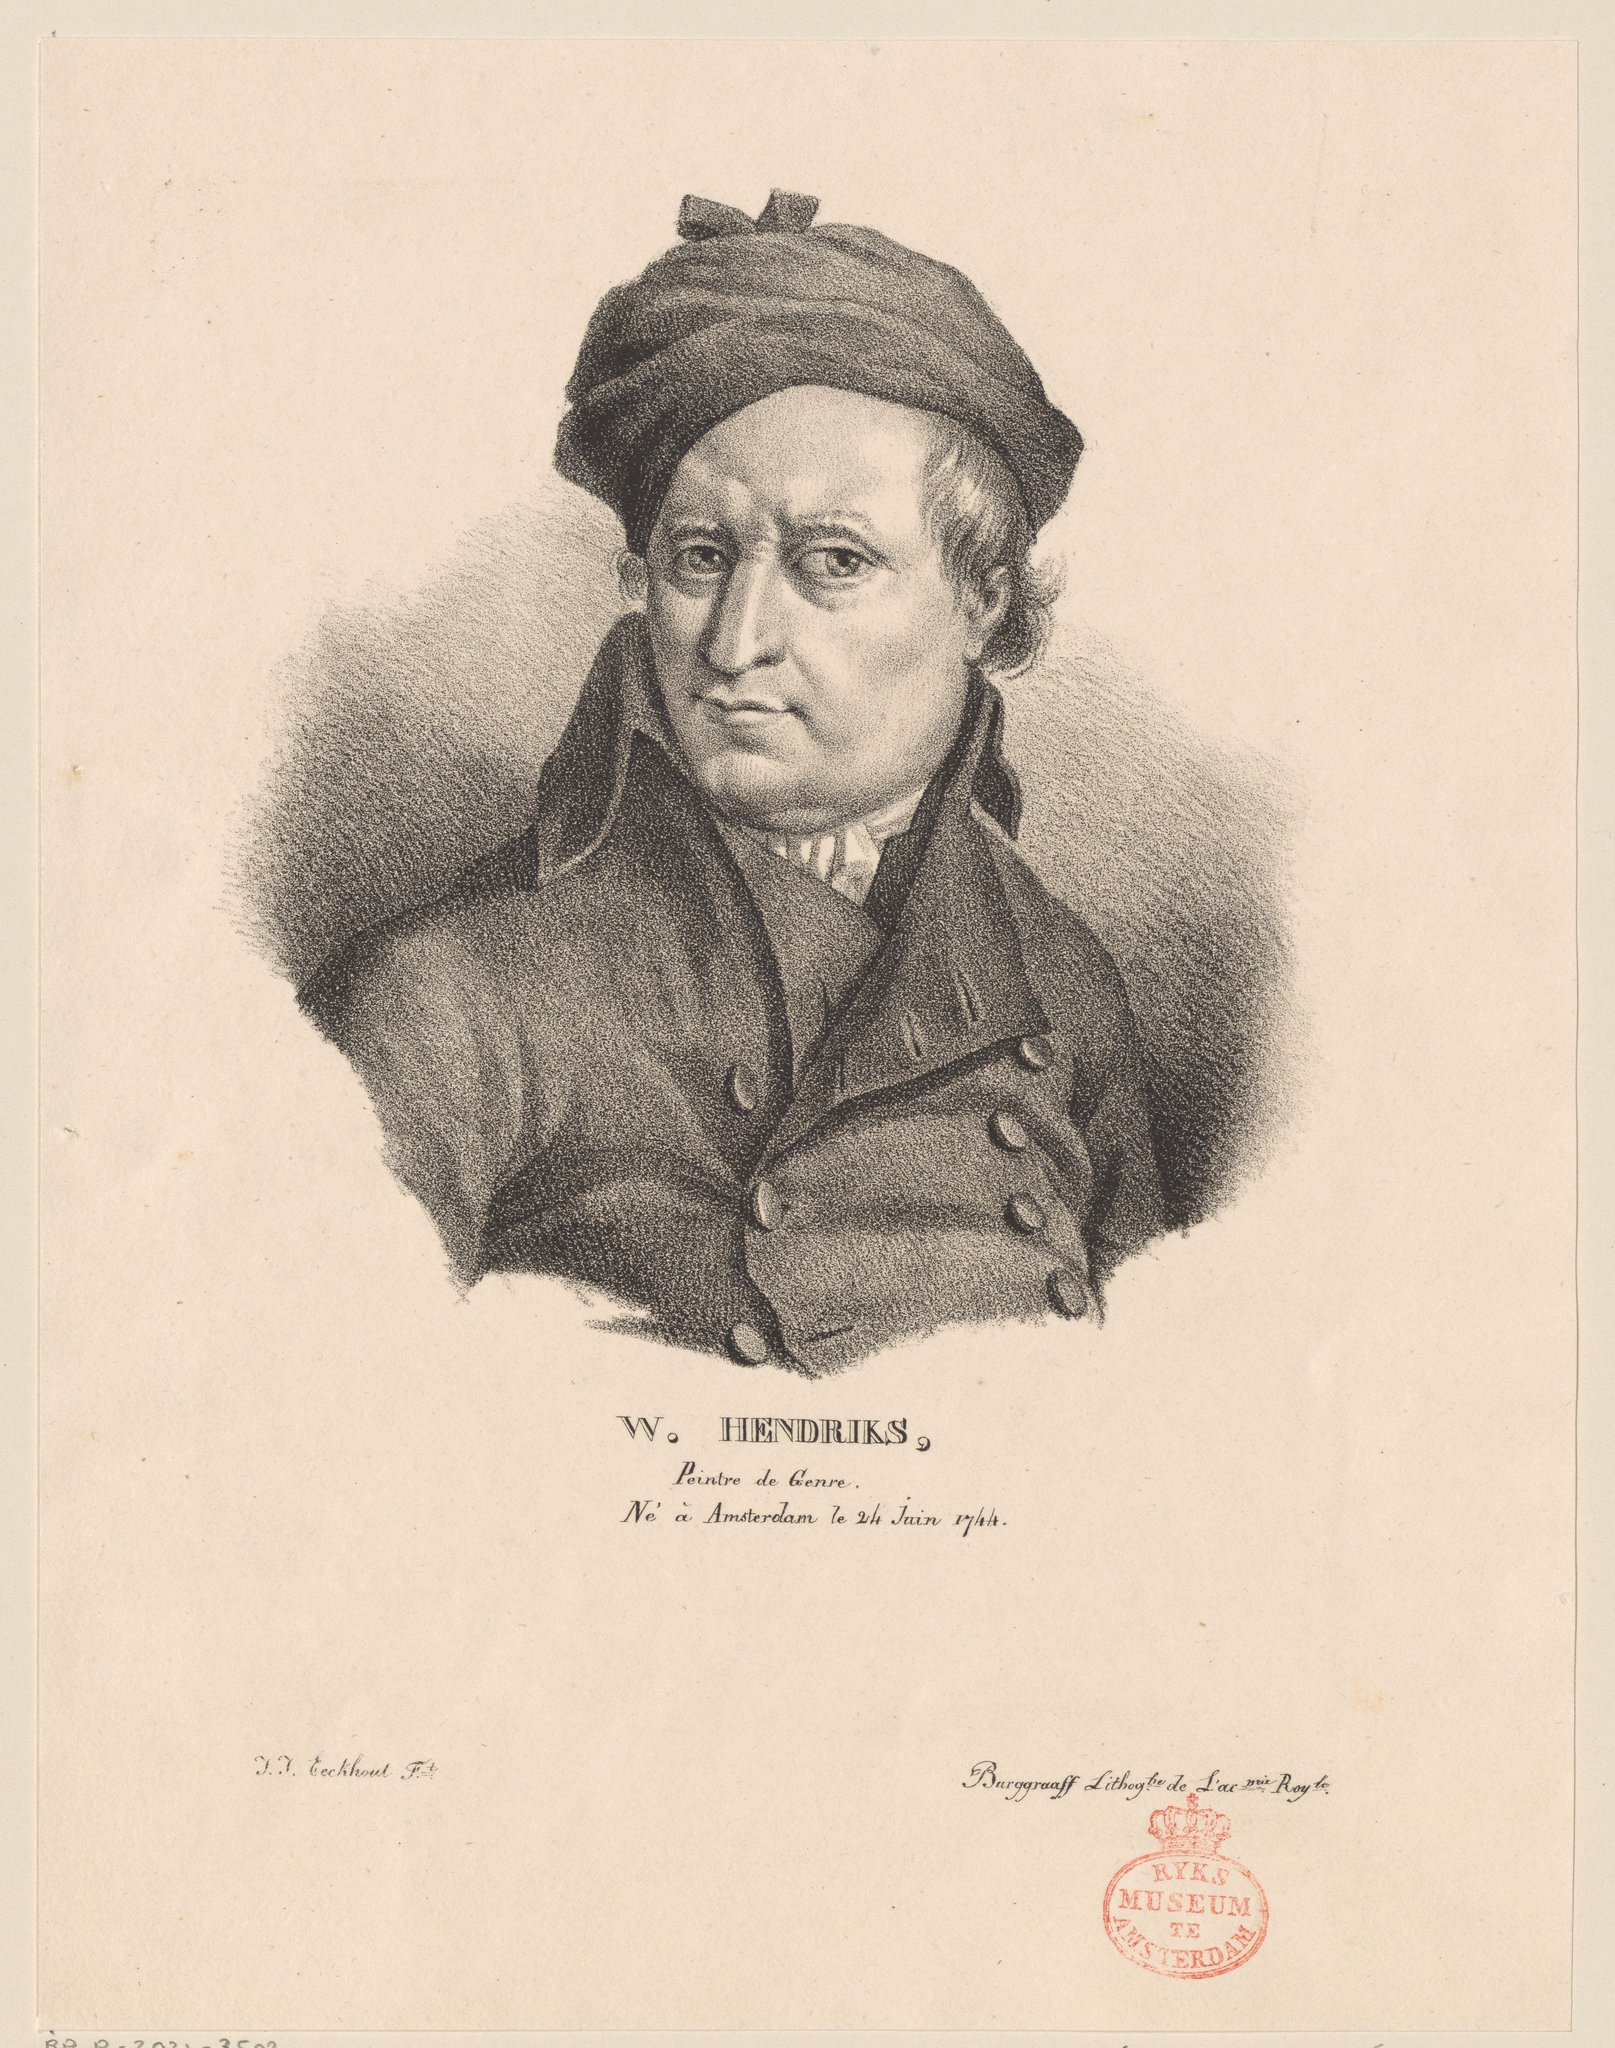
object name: print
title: Portret van Wybrand Hendriks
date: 1820-1861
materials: paper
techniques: lithograph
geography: brussels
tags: amsterdam, painter, print maker, draughtsman, wybrand hendriks, historical persons, portrait, self-portrait of painter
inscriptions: collector's mark: Lugt 12